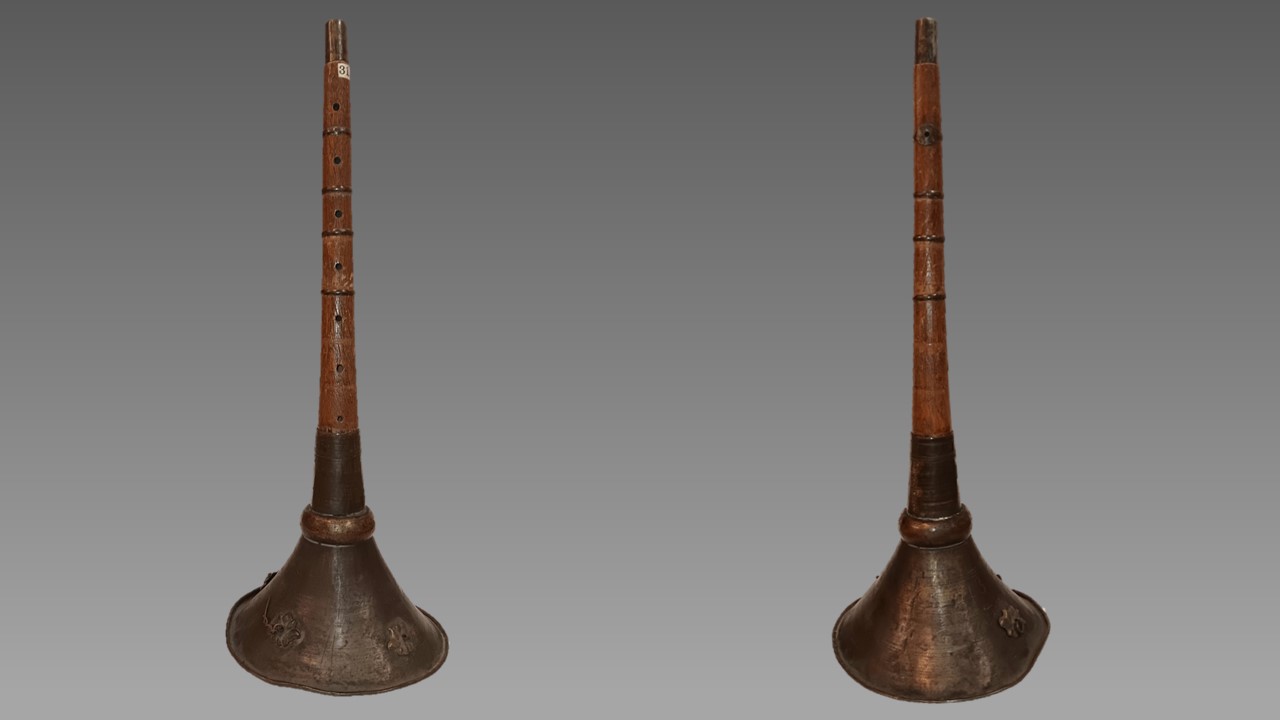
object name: bish khur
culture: russian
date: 1867-1900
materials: brass, wood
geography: russia